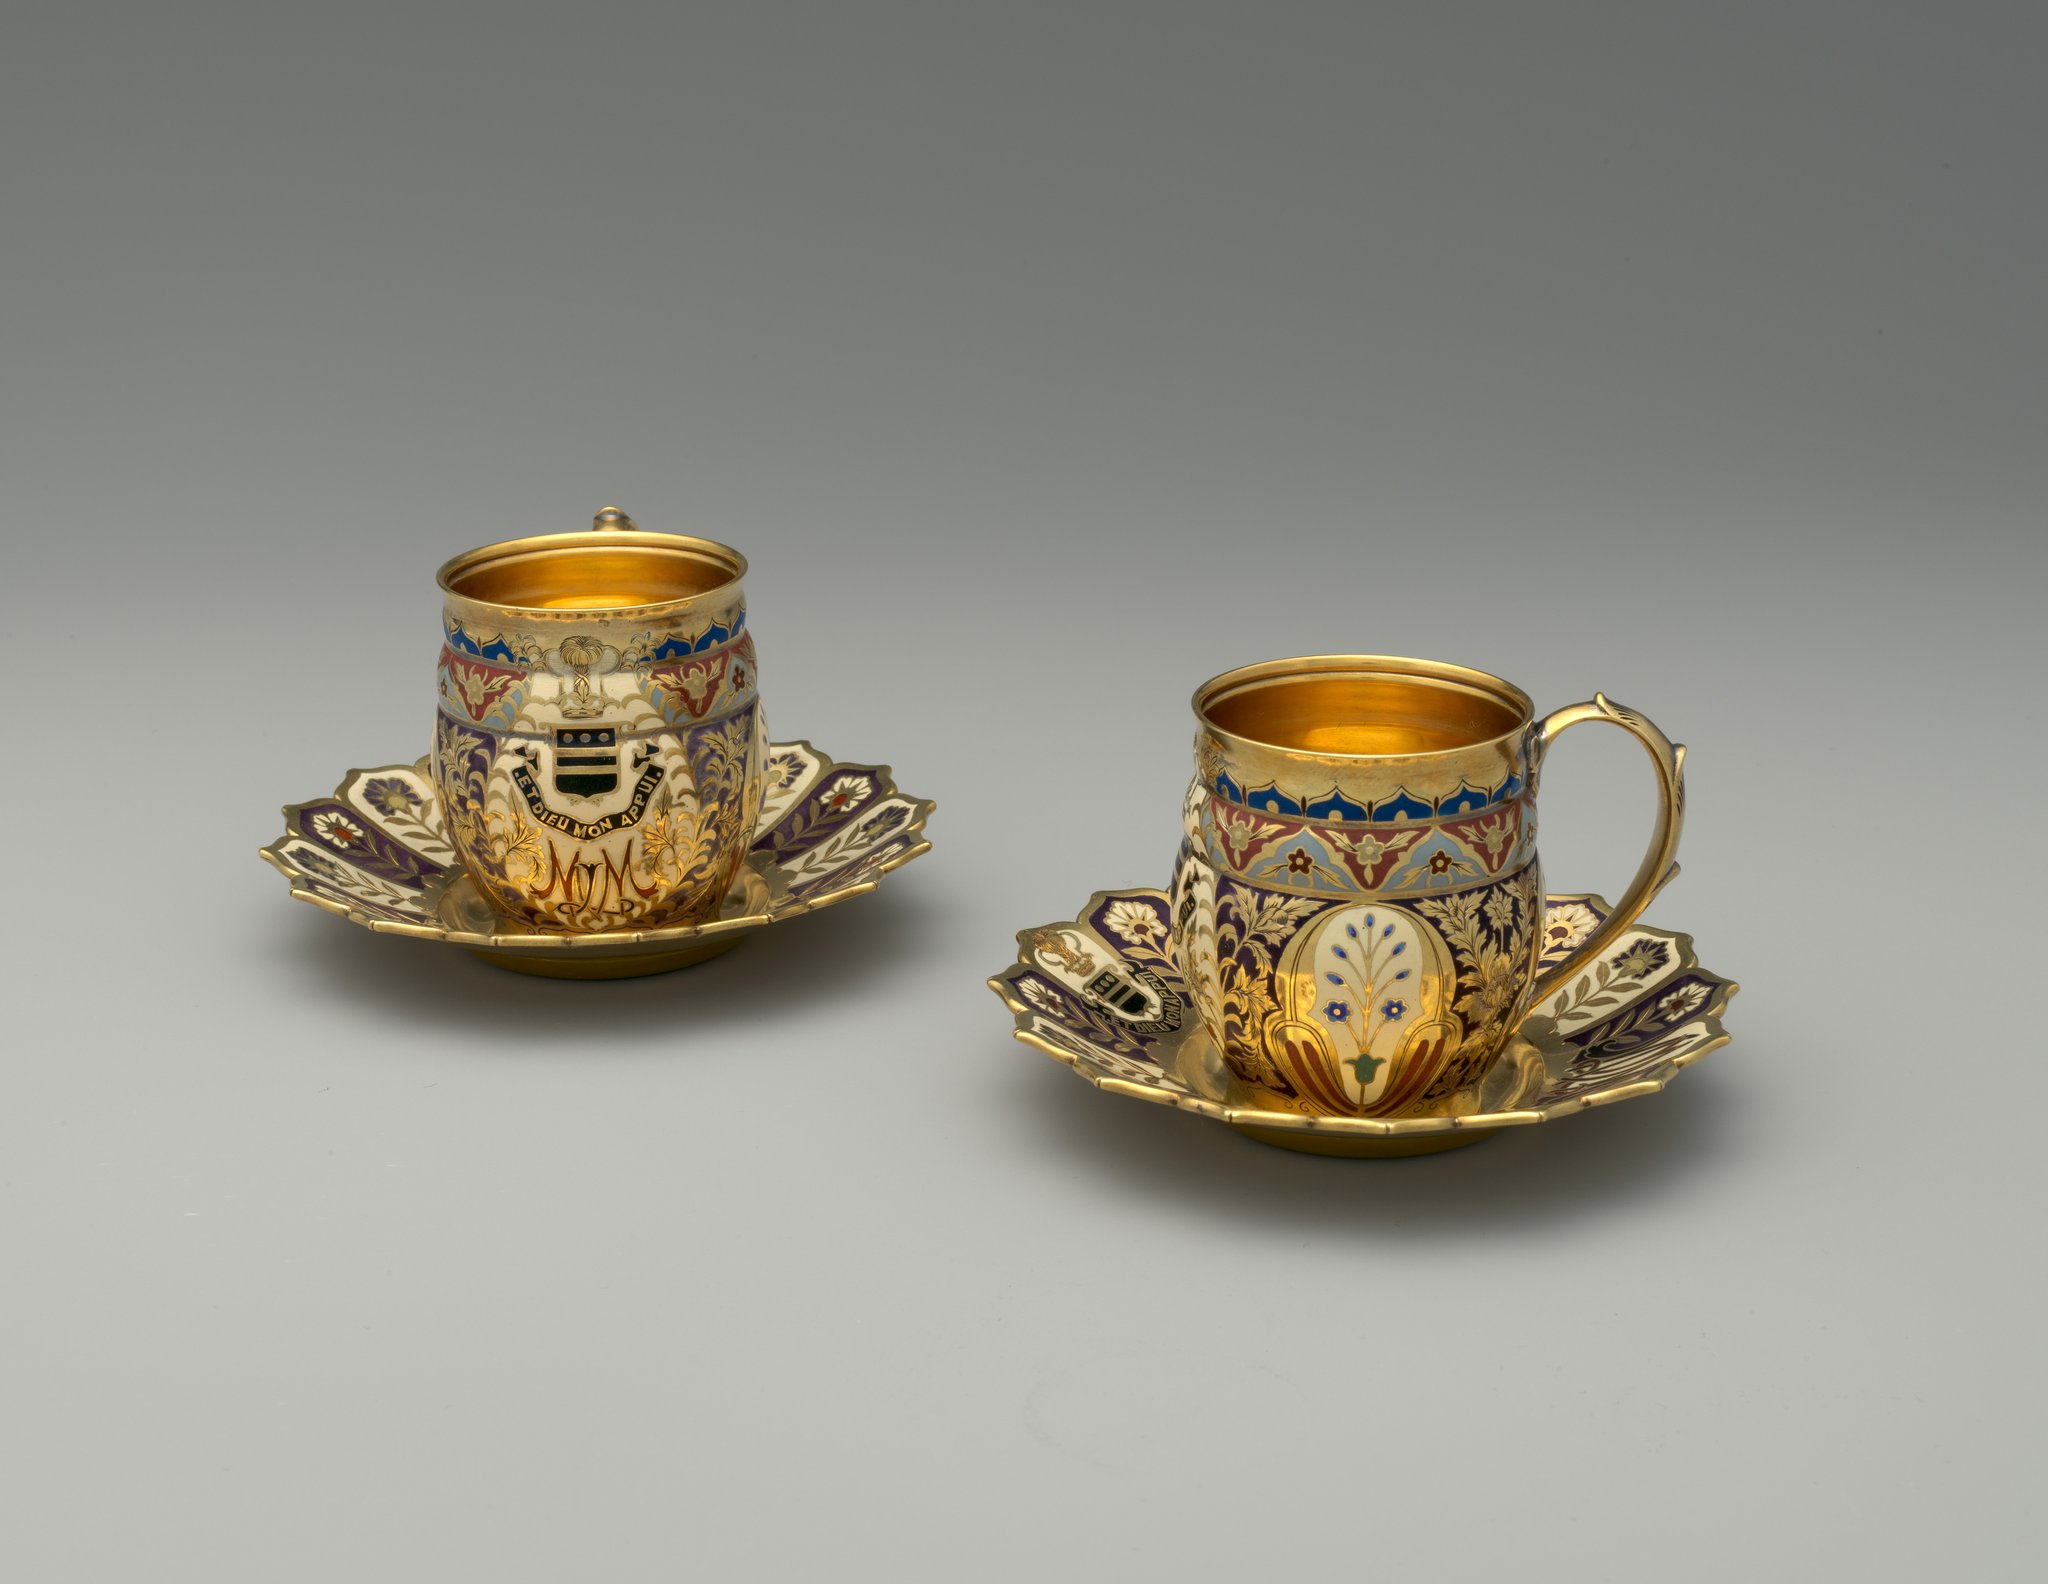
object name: cup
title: Two cups and saucers from the Mackay Service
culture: american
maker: tiffany & co.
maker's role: maker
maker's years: 1837-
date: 1878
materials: enamel, silver gilt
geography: united states